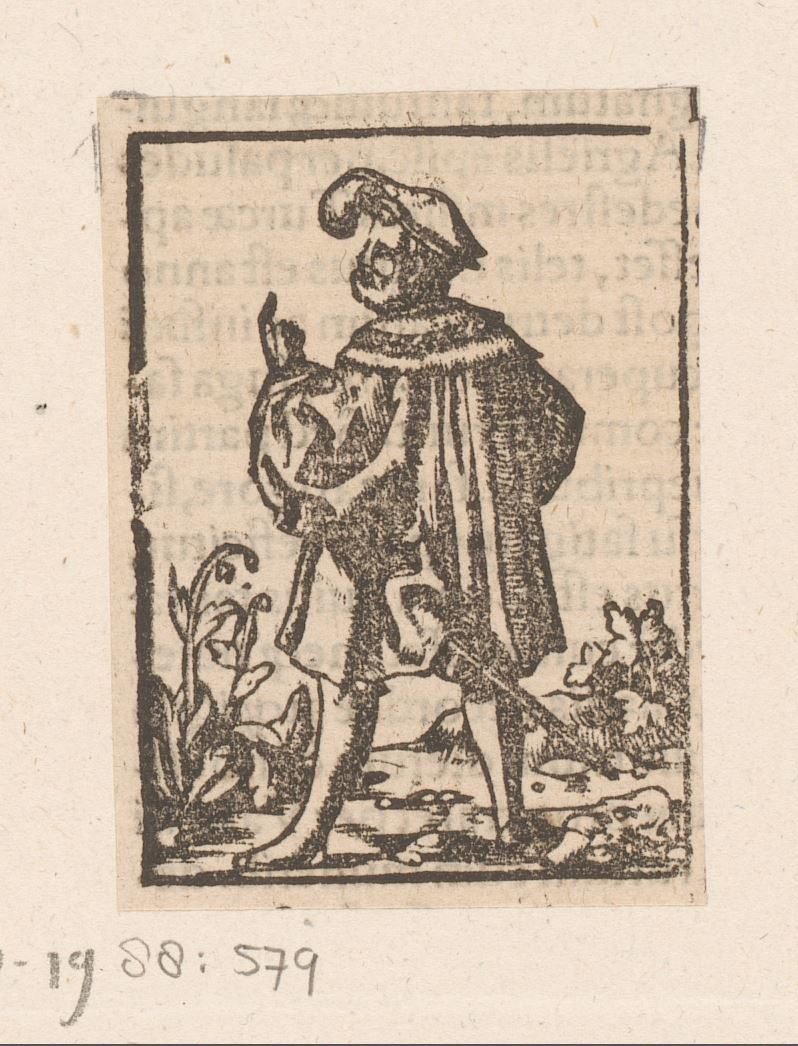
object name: print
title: Staande man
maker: Anonymous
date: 1500-1599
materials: paper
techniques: woodcut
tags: adult man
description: Prent afkomstig uit een onbekende publicatie.